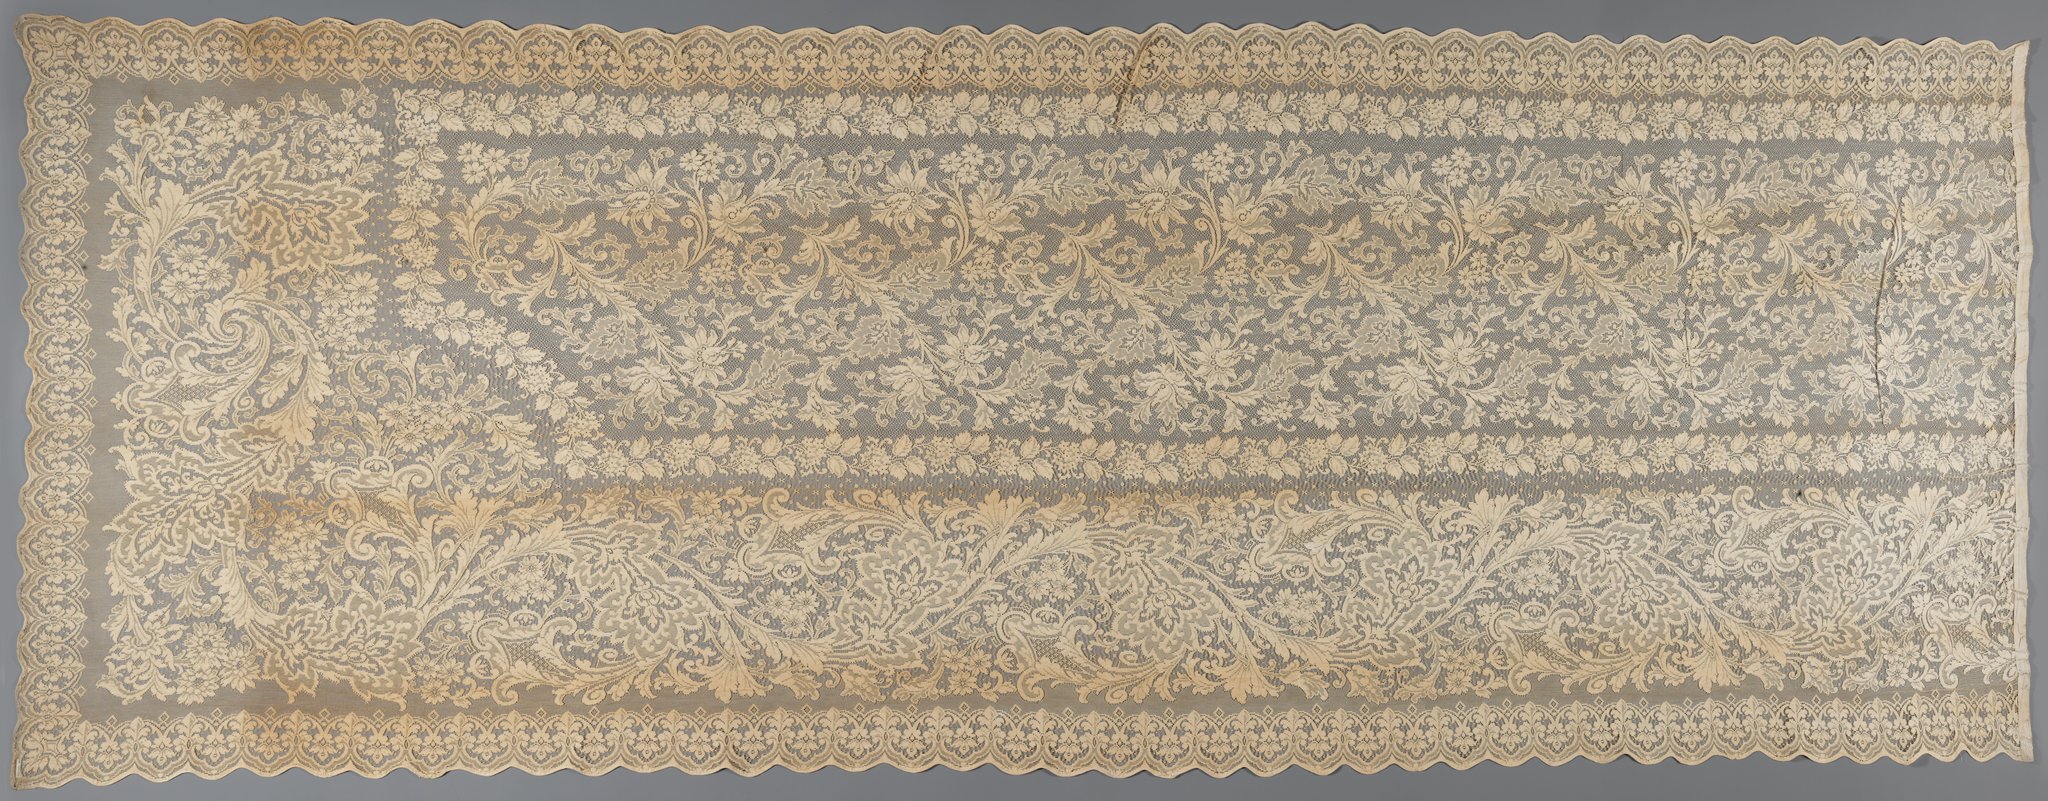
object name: sheer curtain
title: Vitrage van machinale kant met opgaande bloem- en bladranken binnen schulpranden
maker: Anonymous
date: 1890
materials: cotton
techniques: lace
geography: plauen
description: Vitrage van machinale kant. Het patroon heeft opgaande bloem- en bladranken binnen drie schulpranden. De vitrage heeft aangenaaide ringen.